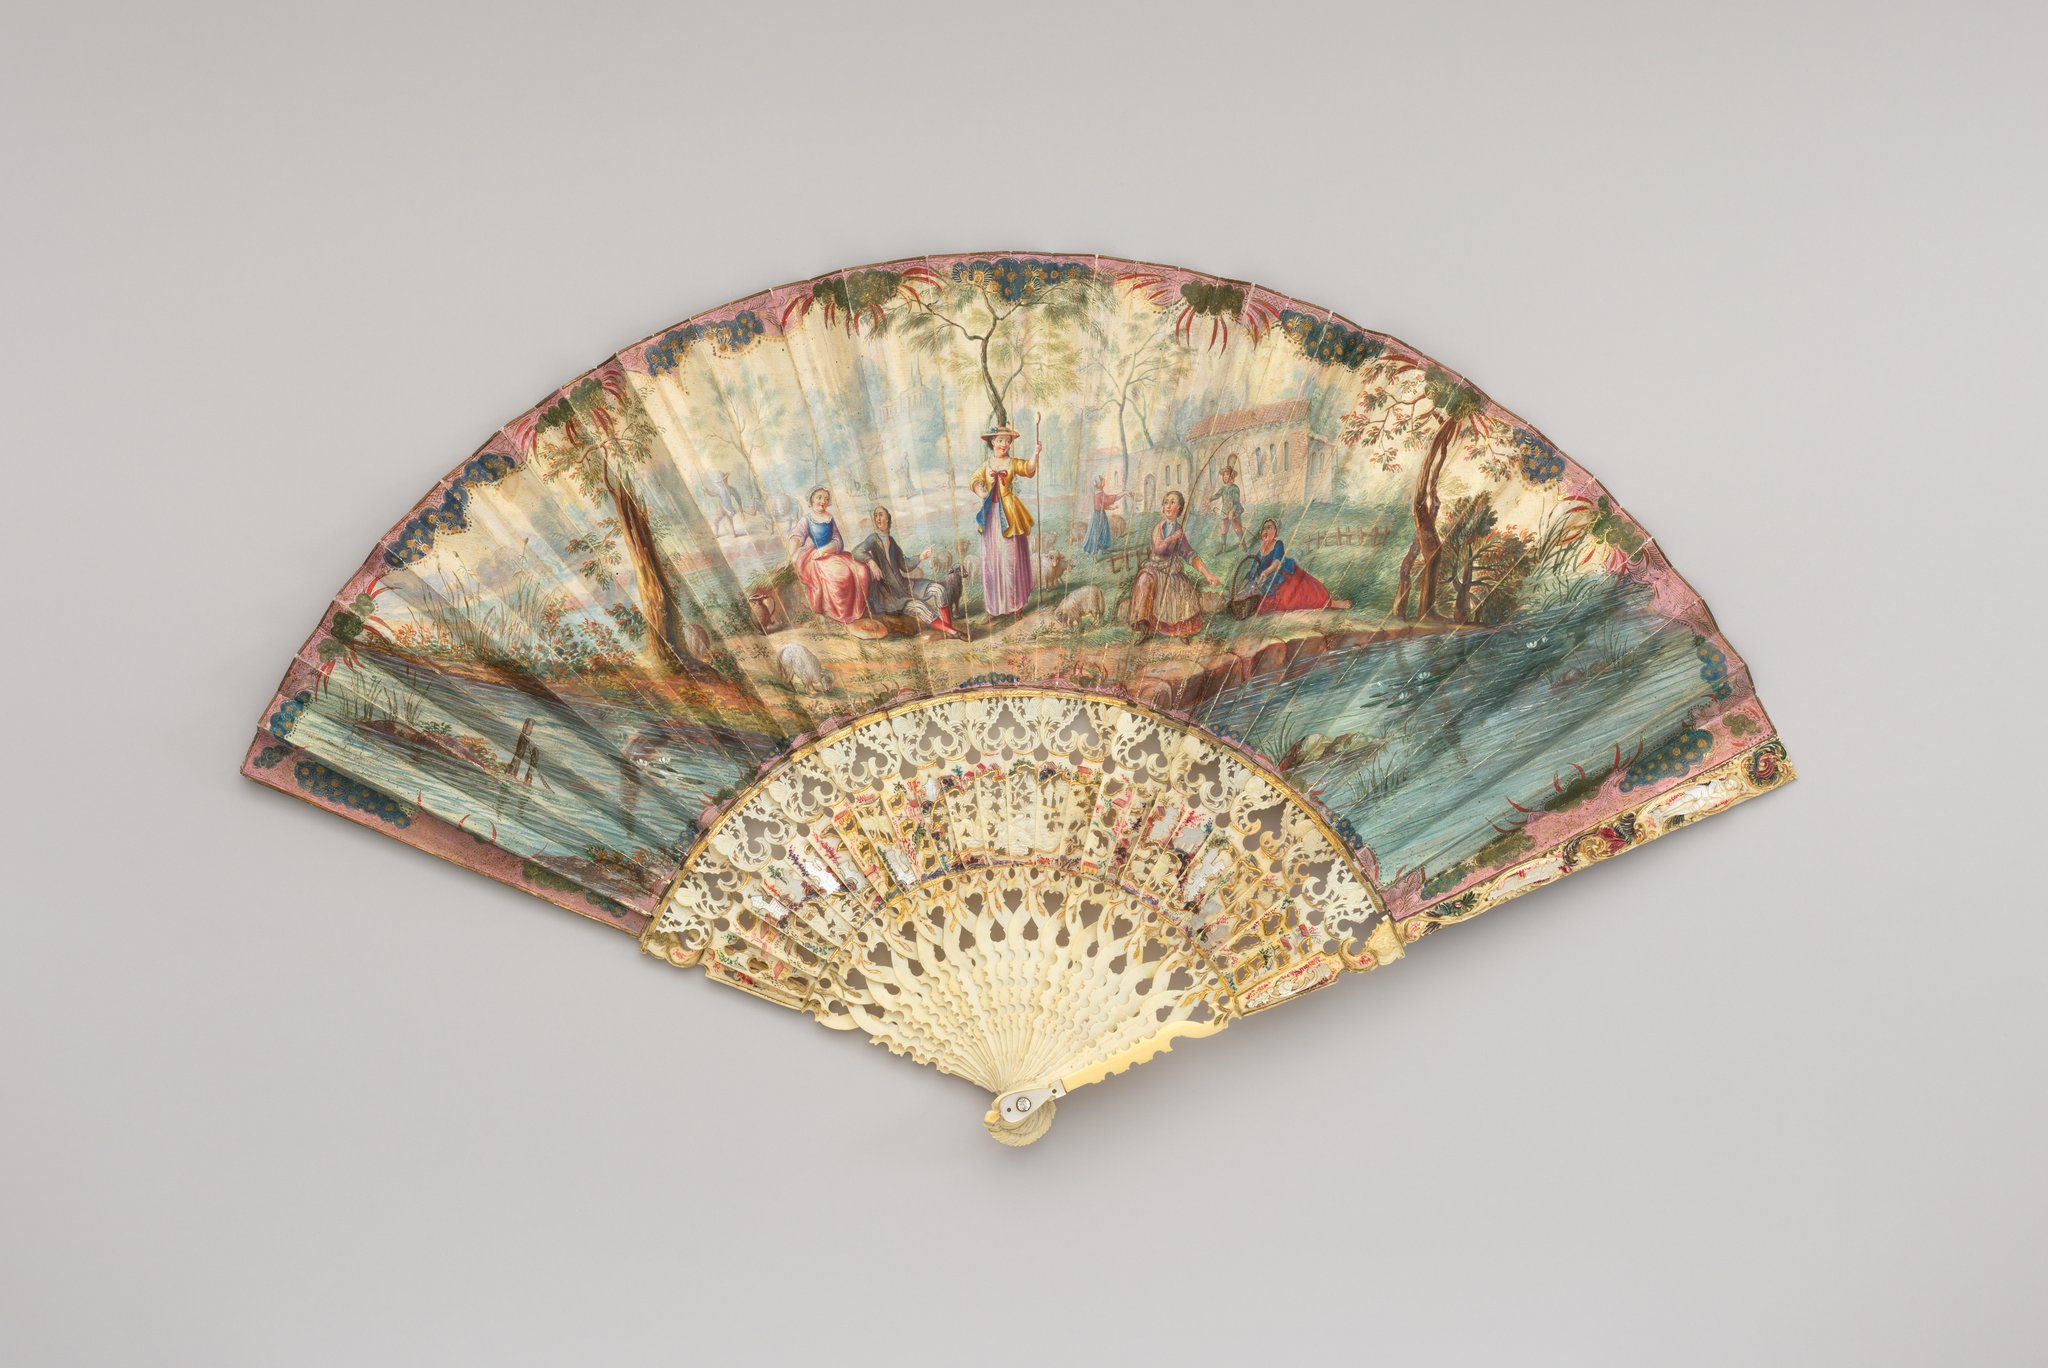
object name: fan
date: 1701-1800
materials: glass, ivory, mother of pearl, paper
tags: men,women,fishing